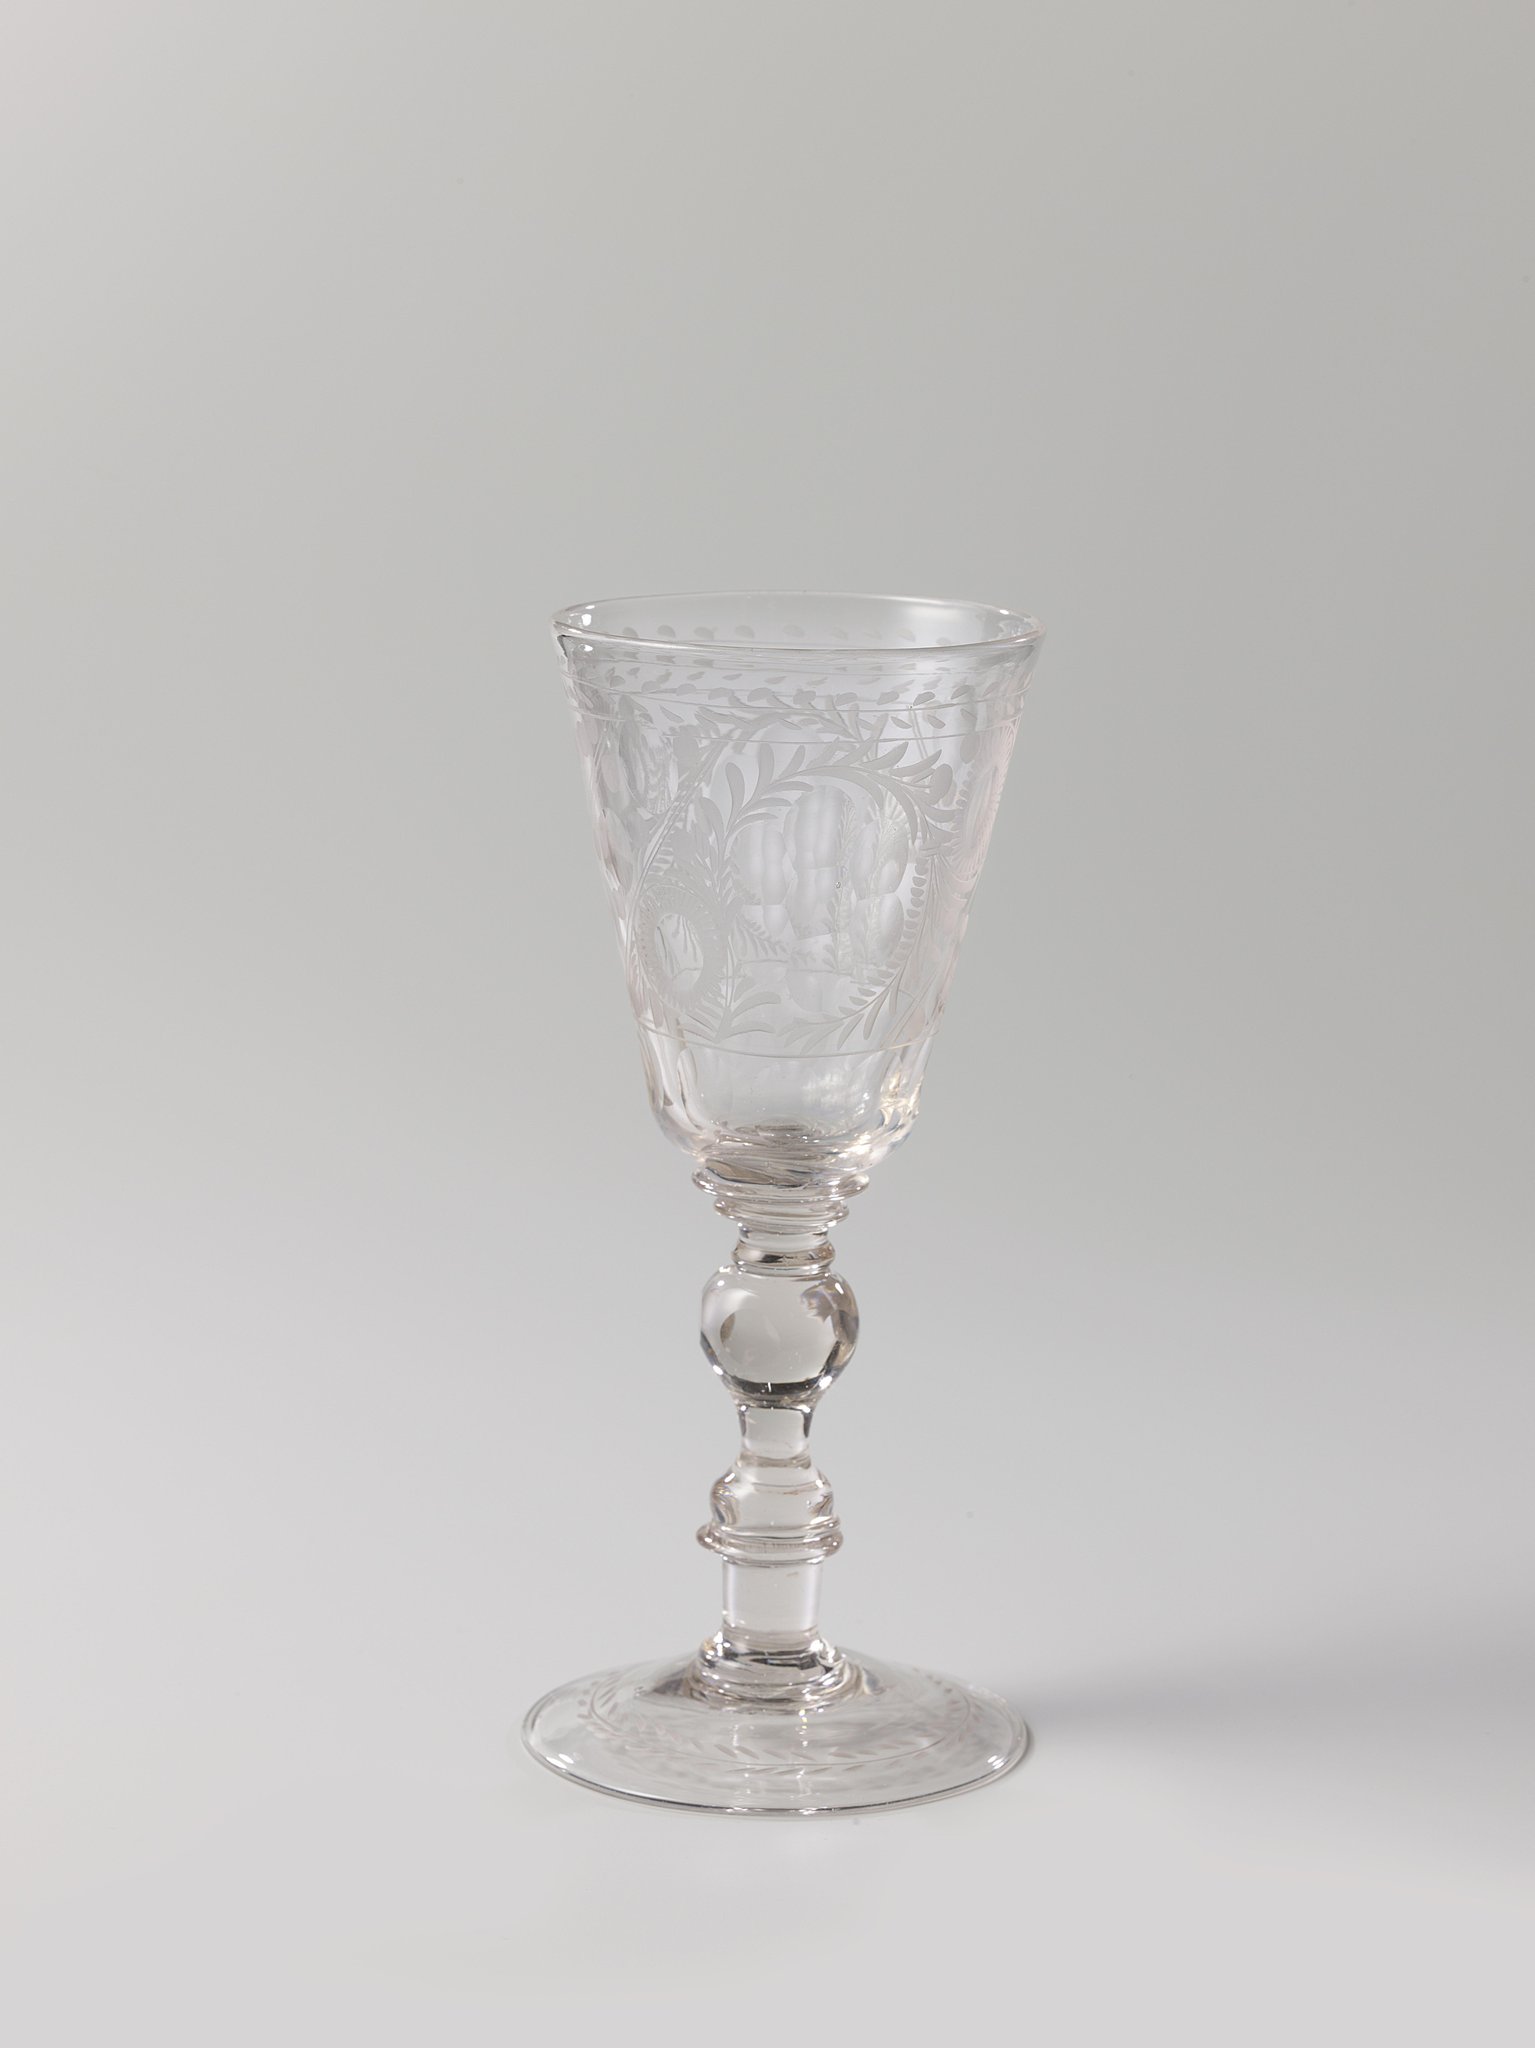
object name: goblet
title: Bokaal met zonnebloemen, stippen en ovalen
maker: Anonymous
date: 1725-1750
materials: glass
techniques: glassblowing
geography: bohemia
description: Gewelfde voet. Balustervormige stam met een knop en schijven. Conische kelk met afgeronde bodem. Op de kelk gegraveerde zonnebloemen, stippen en ovalen.